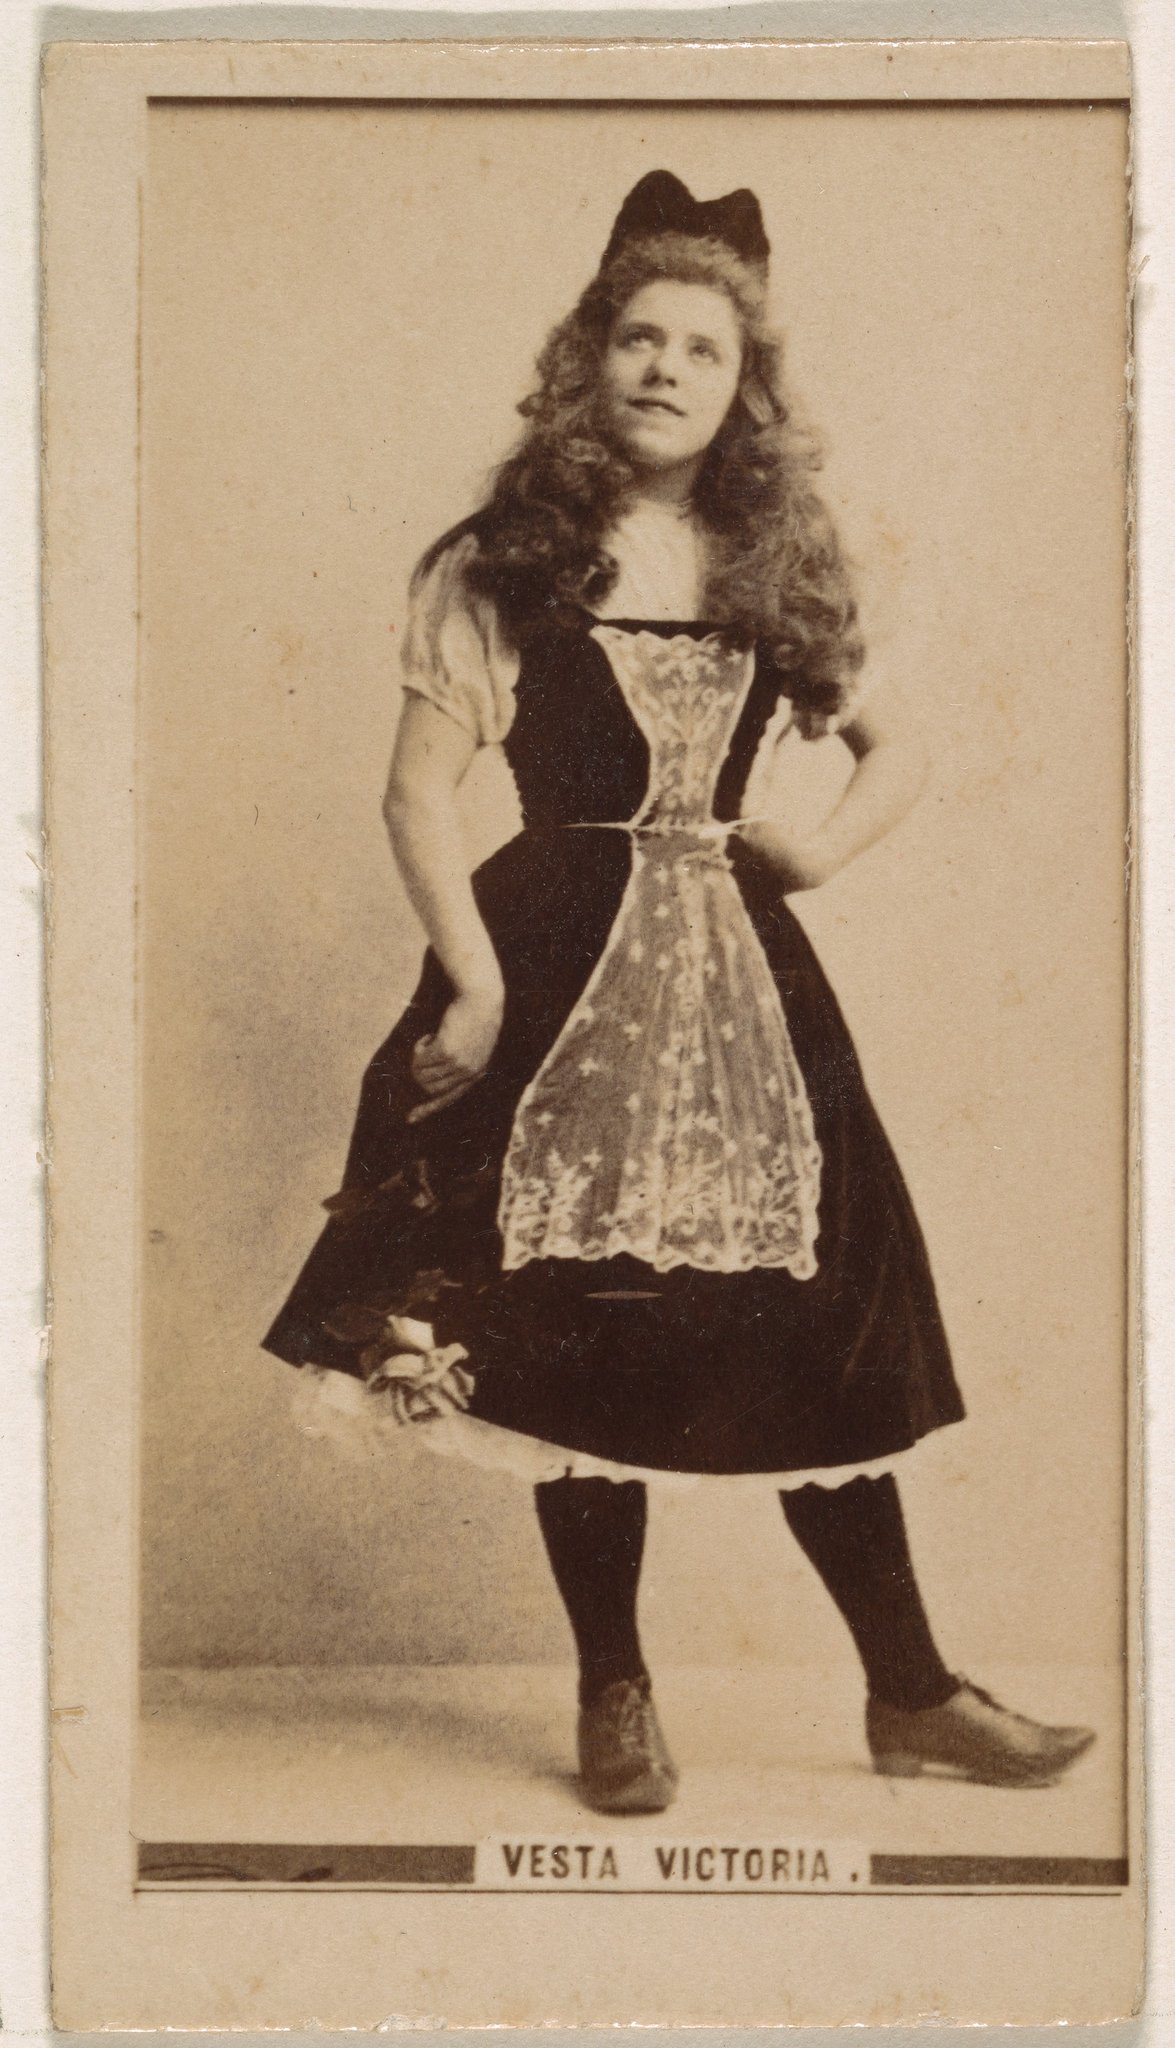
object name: photograph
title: Vesta Victoria, from the Actresses series (N245) issued by Kinney Brothers to promote Sweet Caporal Cigarettes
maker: kinney brothers tobacco company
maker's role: publisher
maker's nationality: american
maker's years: 1869-2011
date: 1890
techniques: albumen silver print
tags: portraits,women,actresses